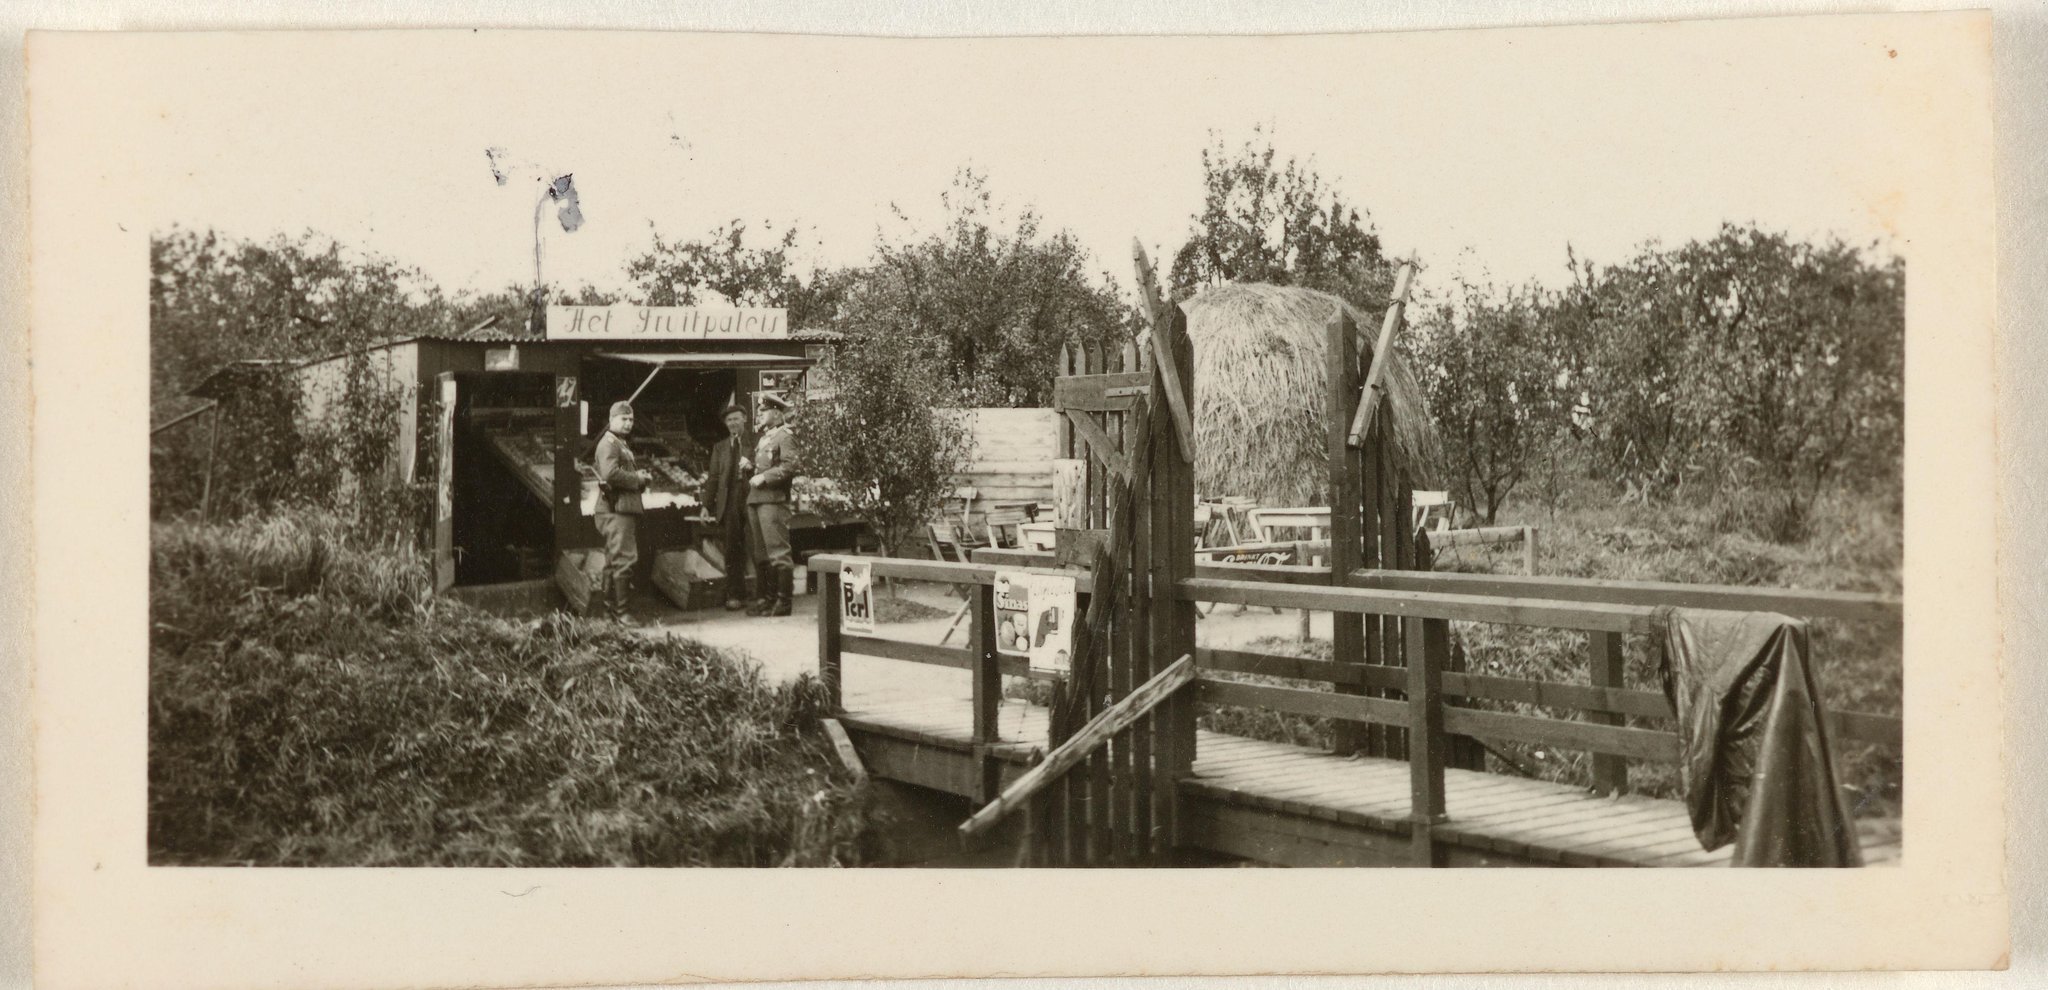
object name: photograph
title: Twee Wehrmacht militairen bij een kraampje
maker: Anonymous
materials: photographic support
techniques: gelatin silver print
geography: netherlands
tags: occupier and civilians, occupation ~ war, netherlands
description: Twee Wehrmacht militairen staan bij een kraampje ergens op het platteland met de eigenaar. Op het kraampje staat: Het Fruitpaleis. Op de voorgrond een bruggetje, erachter een hooiberg.